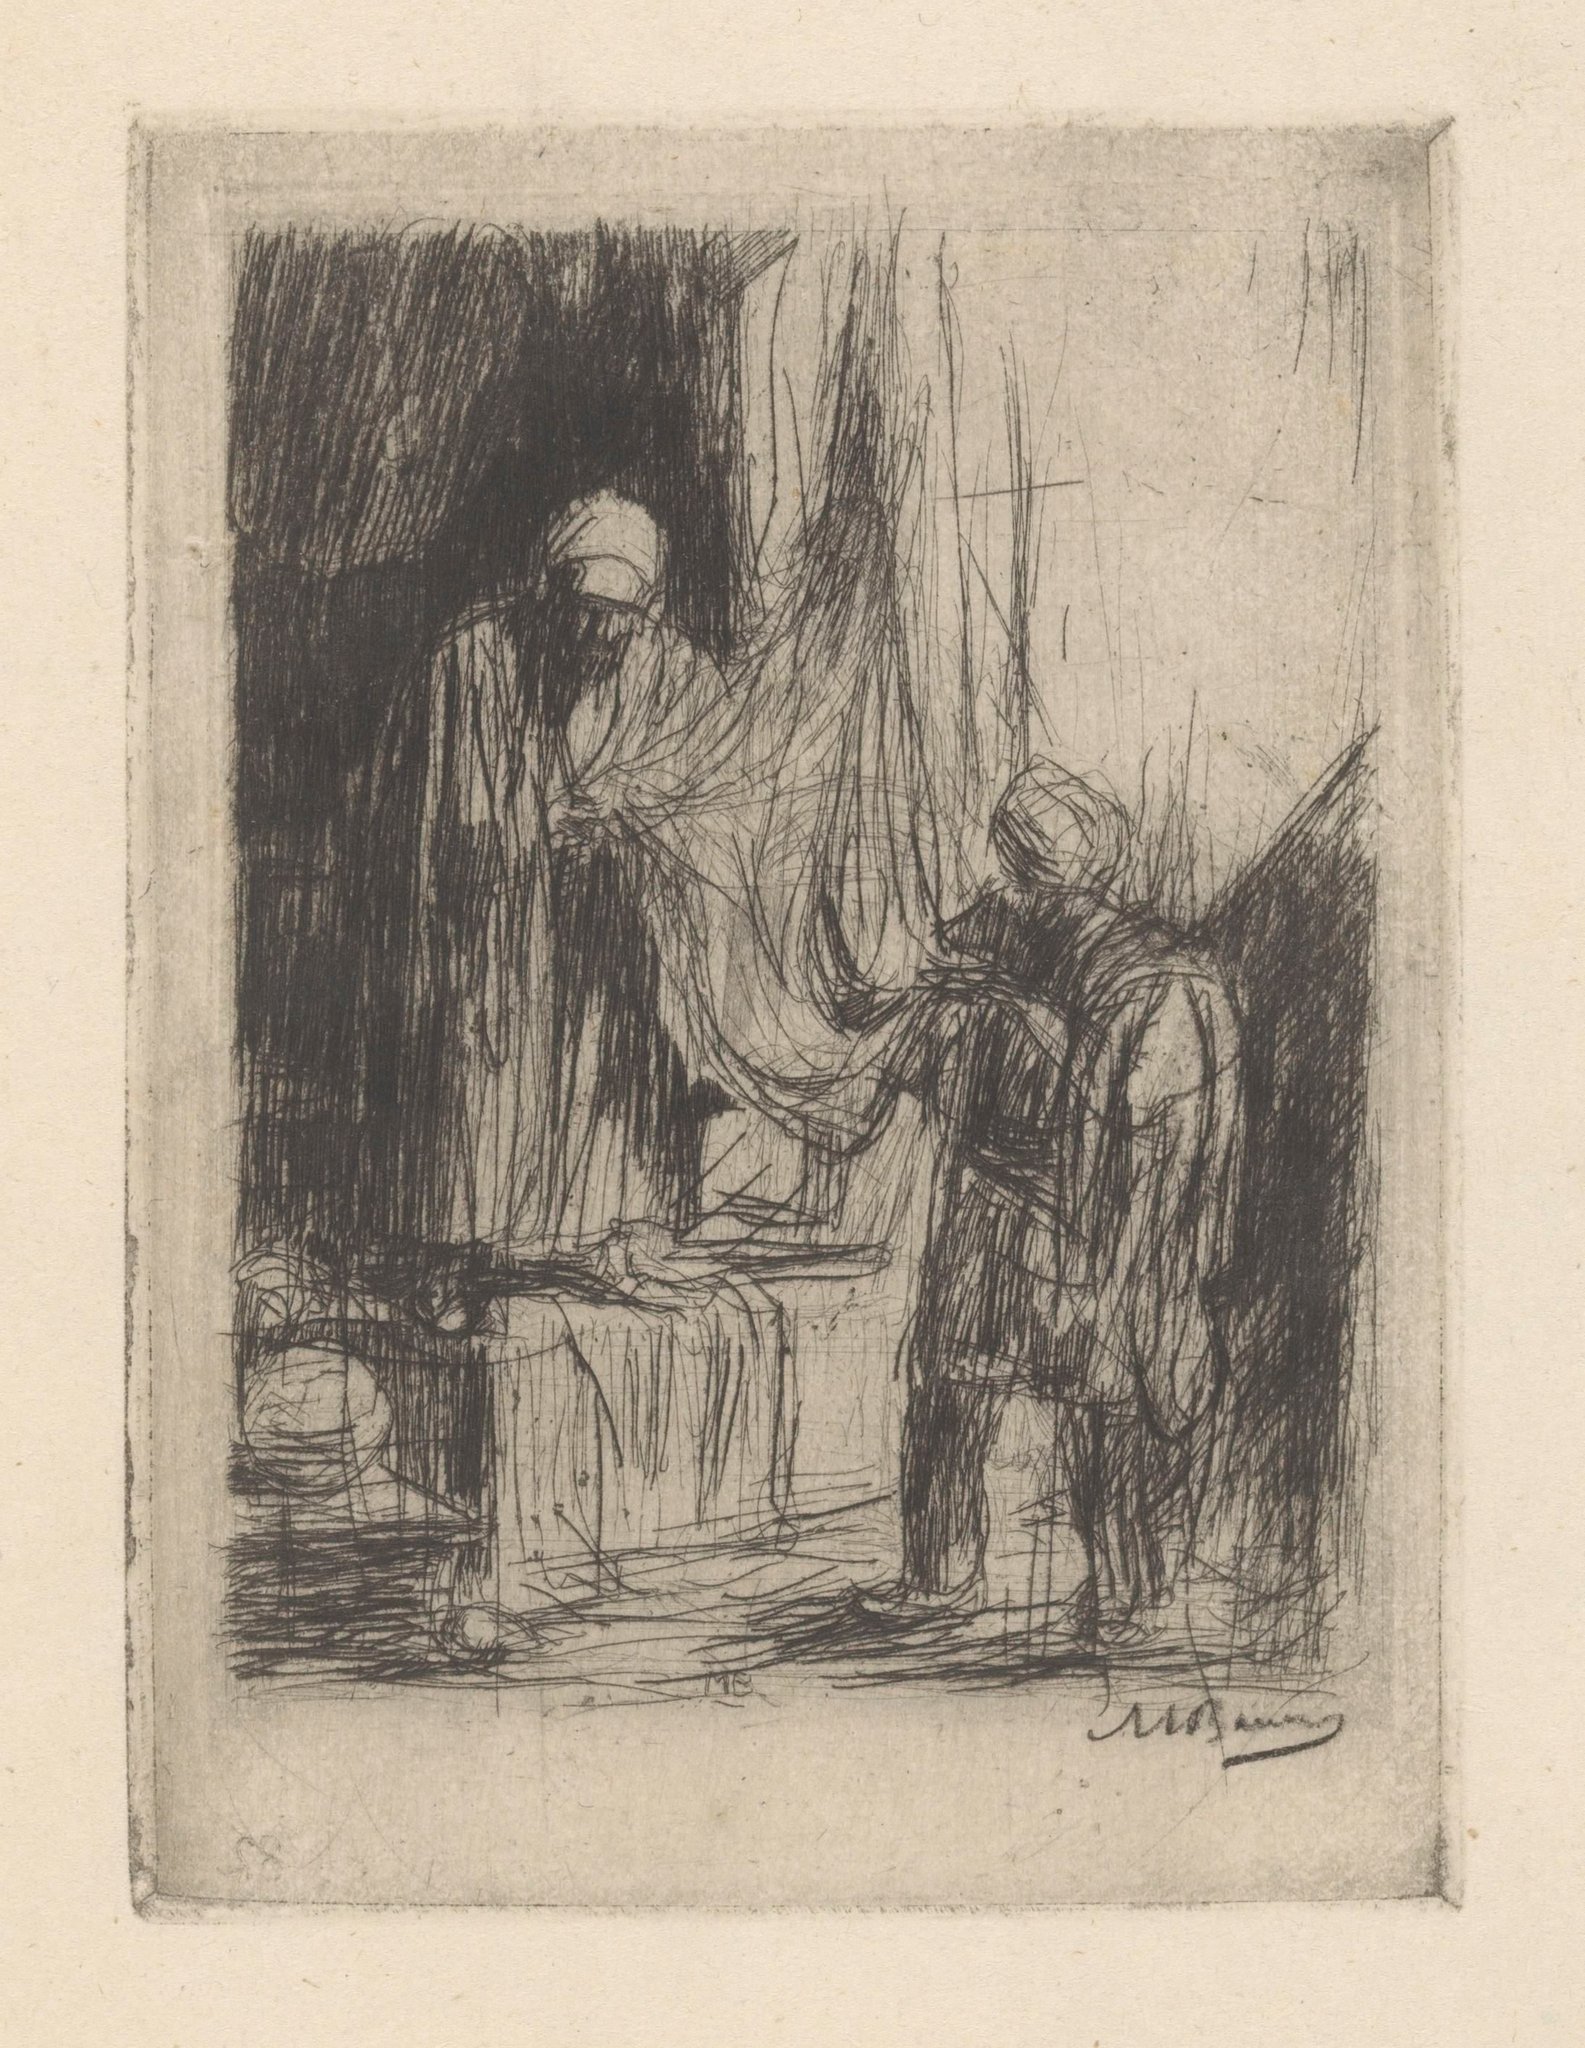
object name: print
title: Ottomaanse winkel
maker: marius bauer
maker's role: draughtsman, print maker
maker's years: 1867-1932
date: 1890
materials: paper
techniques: etching, intaglio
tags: shop, store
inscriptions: collector's mark: Lugt 2760, collector's mark: Lugt 2228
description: Een koopman en een klant in oosterse kleding in een winkel. Beiden houden een doek vast. Onderaan is het nummer 82 in spiegelbeeld gedrukt.